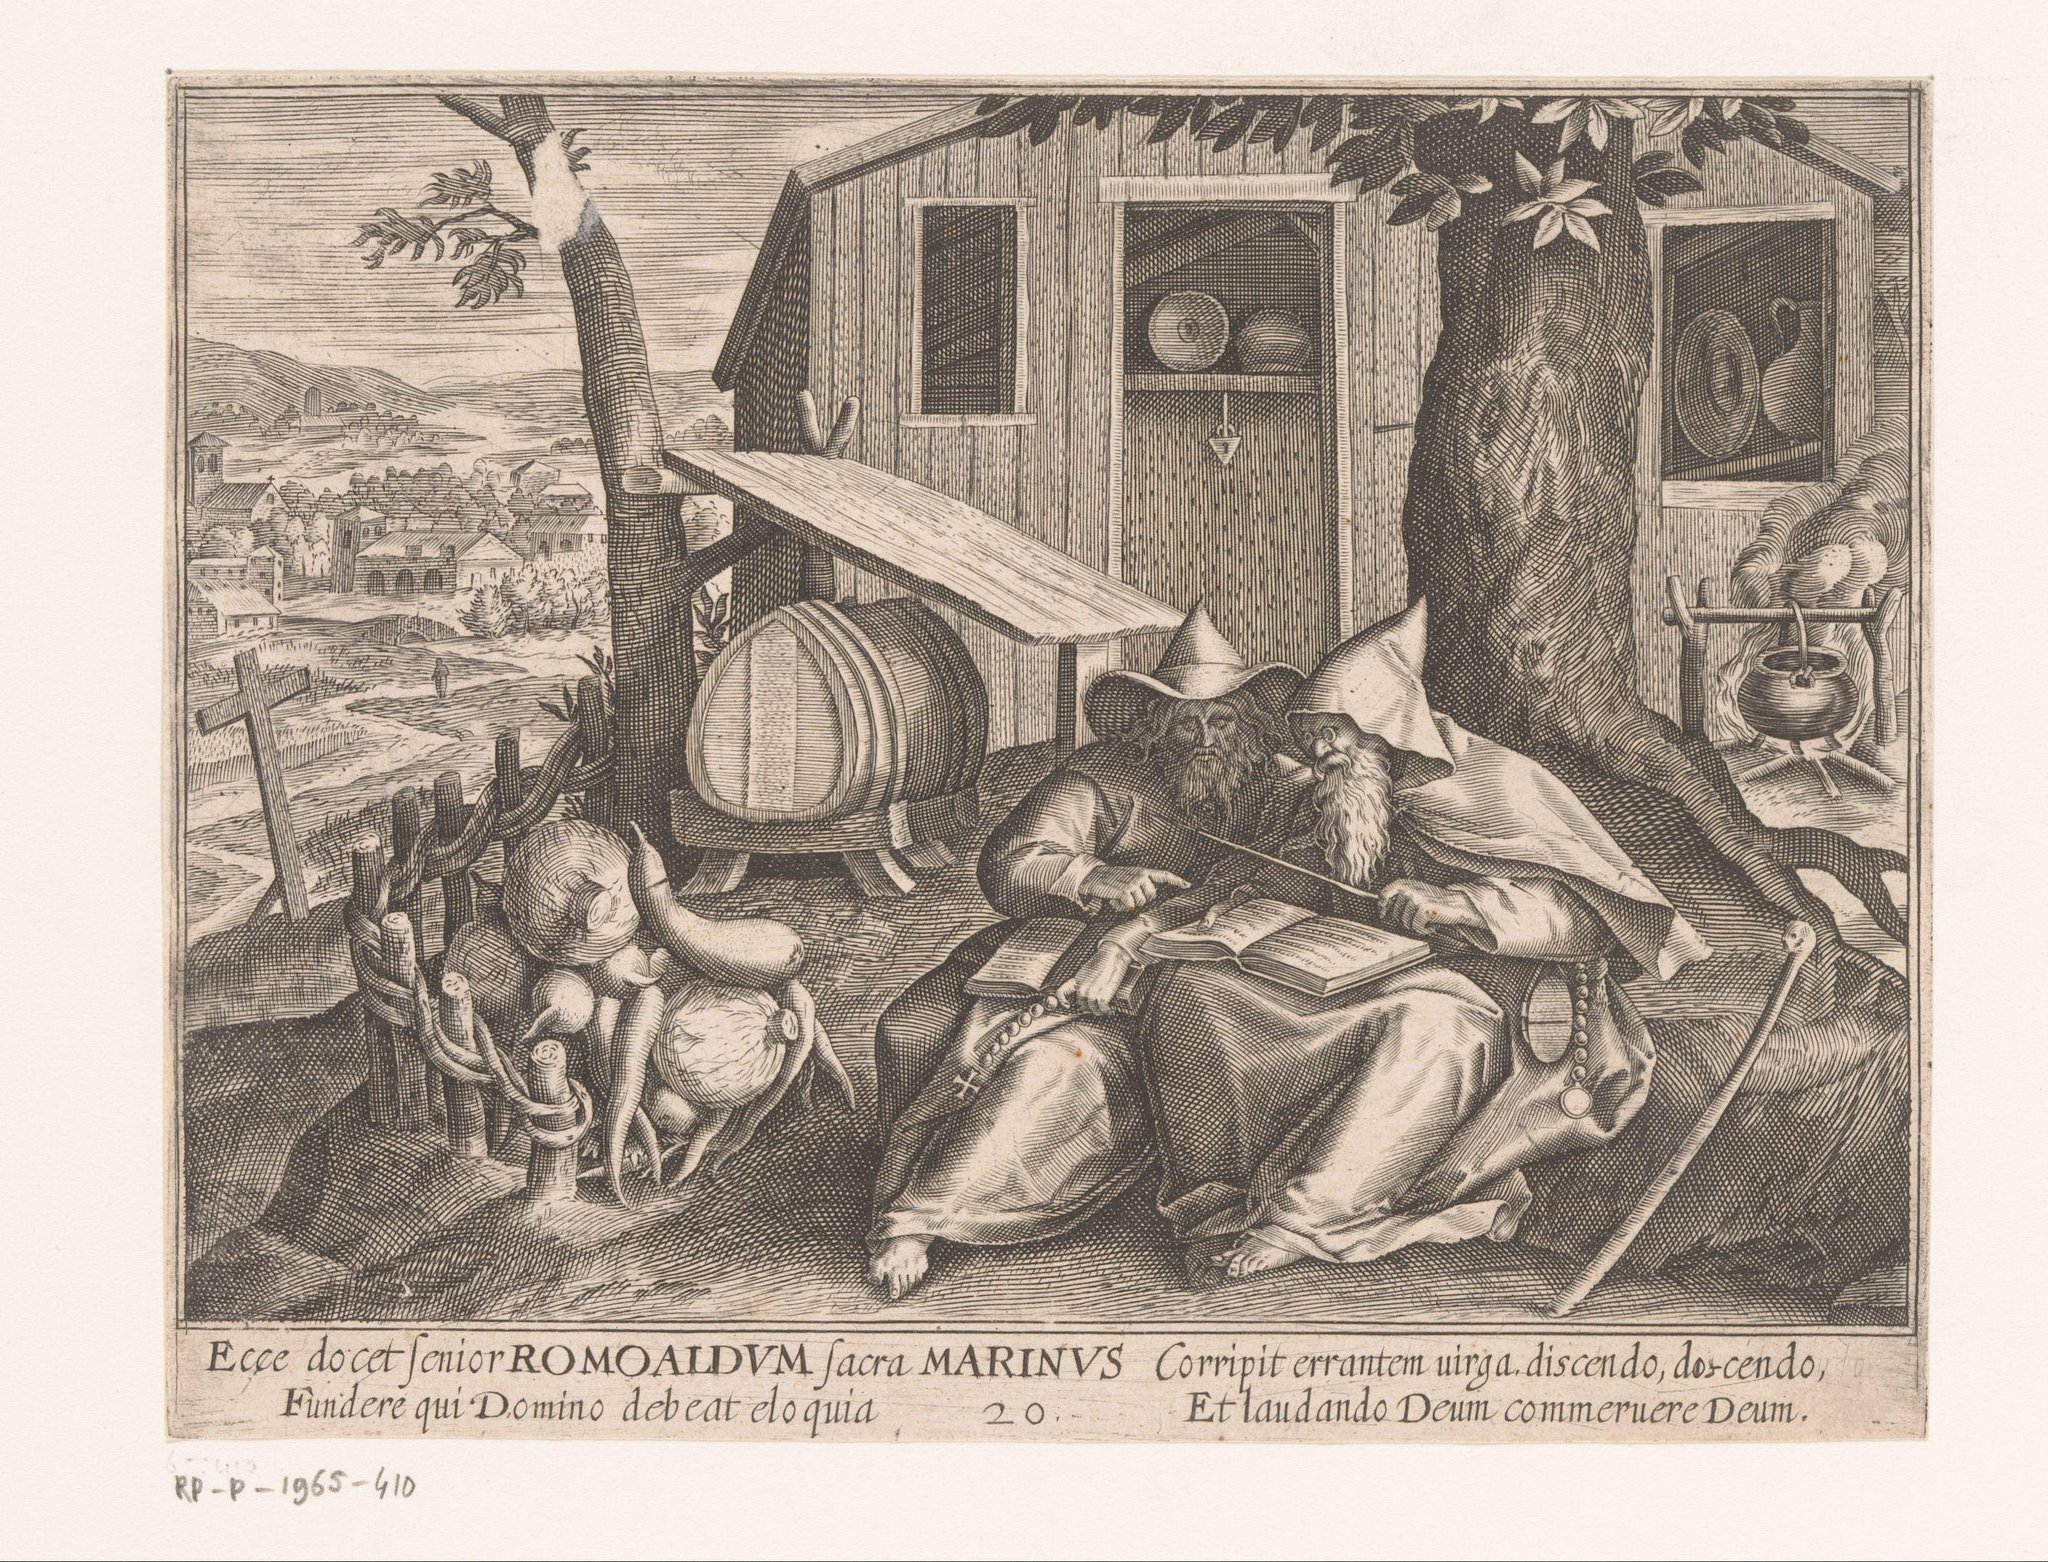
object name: print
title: Heilige Marinus en de heilige Romualdus als kluizenaars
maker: thomas de leu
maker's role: print maker, publisher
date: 1598-1614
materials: paper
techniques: engraving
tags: male saints (with name), anchorite, hermit, the benedictine monk romuald of camaldoli (or ravenna), founder of the camaldolese order; possible attributes: book, t-shaped staff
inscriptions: collector's mark: Lugt 2228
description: Maakt deel uit van een 24-delige serie met titelprent, over het leven van kluizenaars en heremieten naar ontwerp door Maerten de Vos, Johann (I) en Raphaël Sadeler (I), uitgegeven door Thomas de Leu.